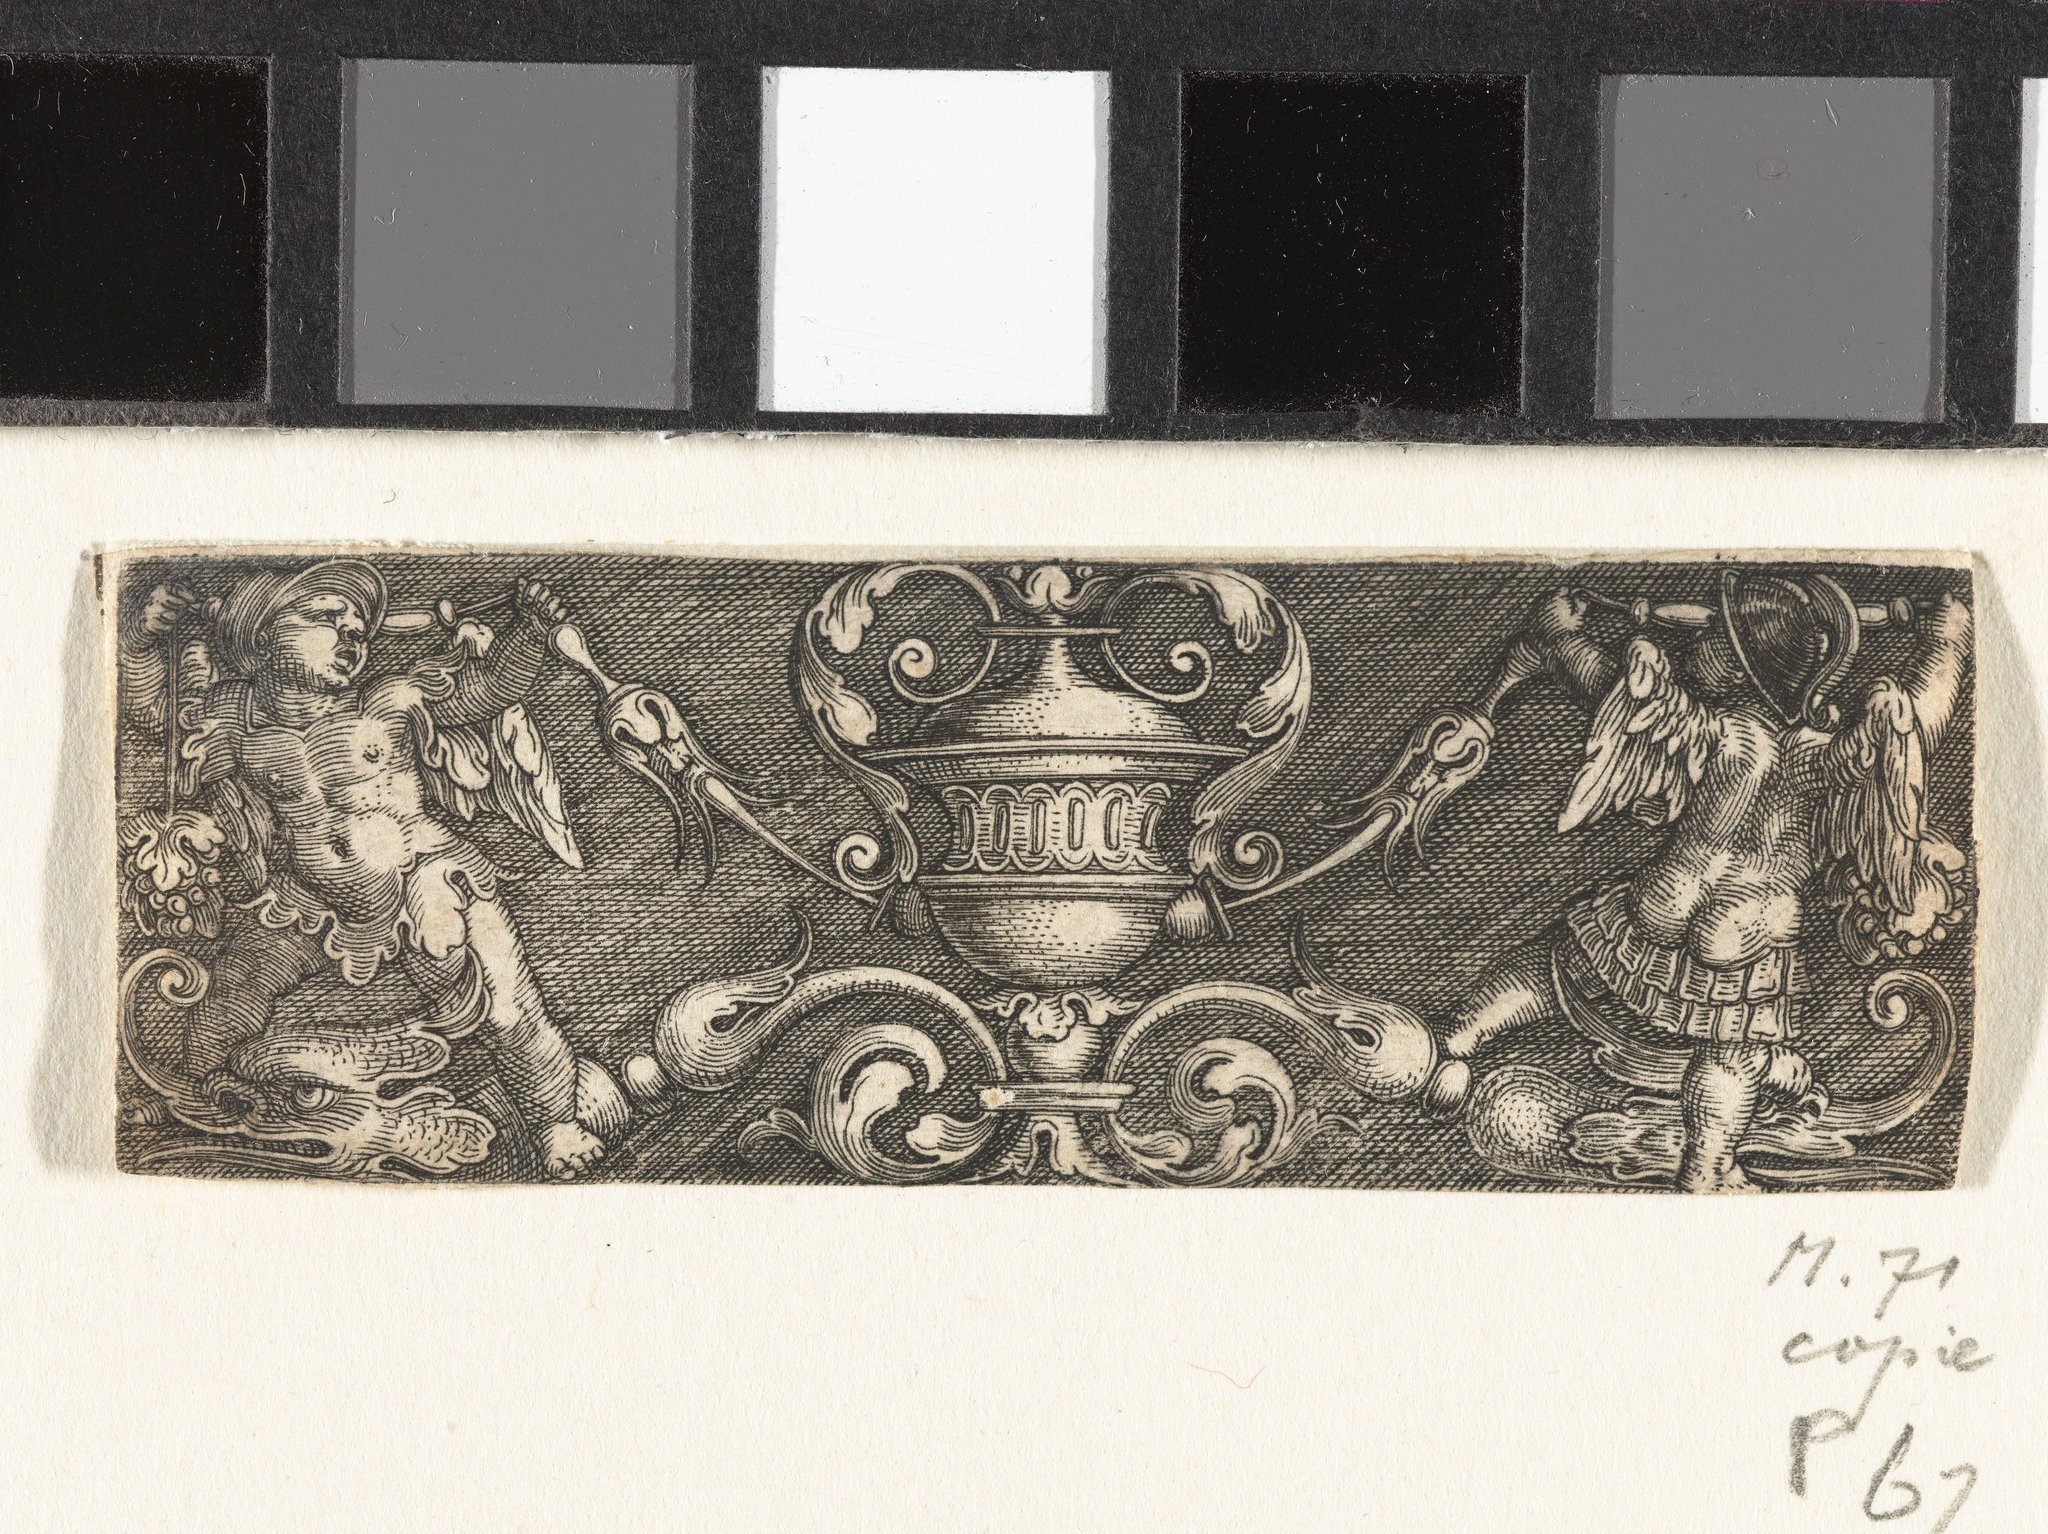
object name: print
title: Fries met vaas tussen twee putti met een helm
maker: monogrammist ac (16e eeuw)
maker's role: print maker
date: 1521-1590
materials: paper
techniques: engraving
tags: swimming mammals: dolphin (+ ornamental variants of animals), cupids: 'amores', 'amoretti', 'putti'